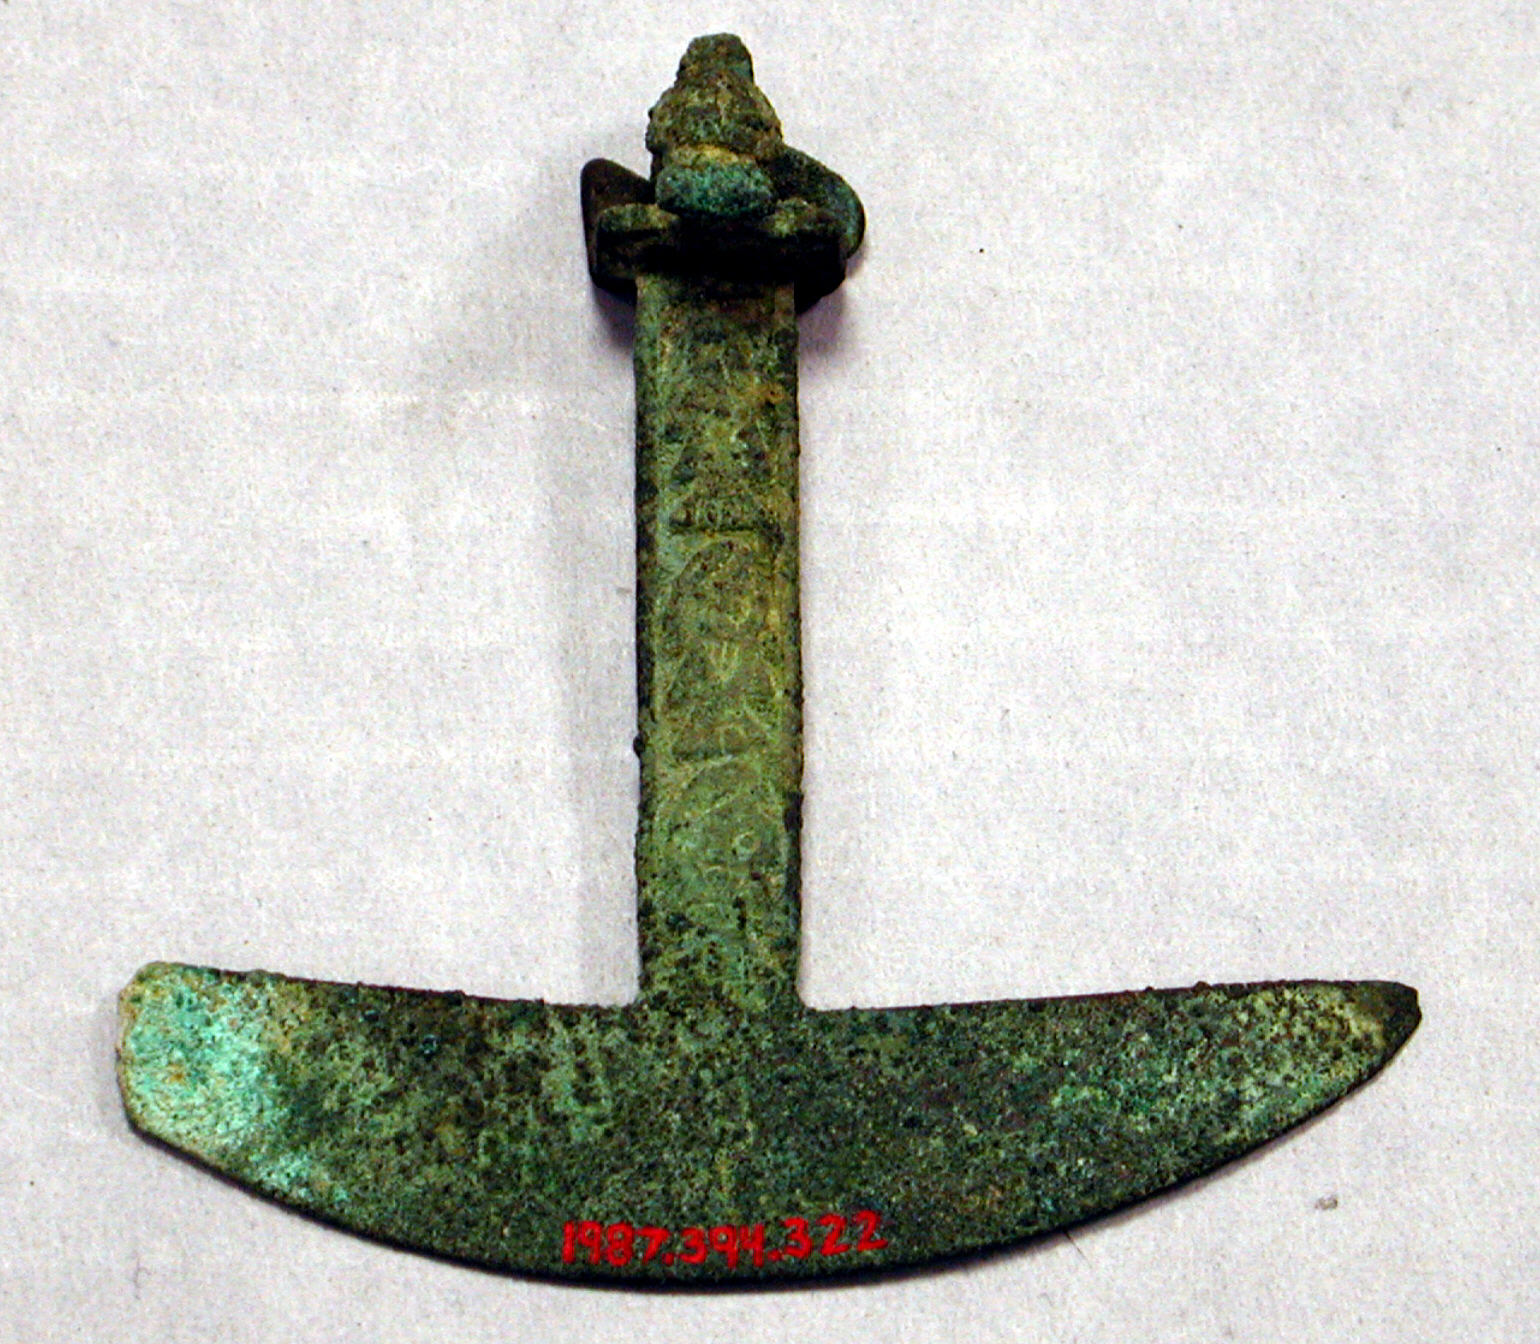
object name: knife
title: Ceremonial Knife (Tumi)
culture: chimú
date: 1101-1500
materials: copper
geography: peru